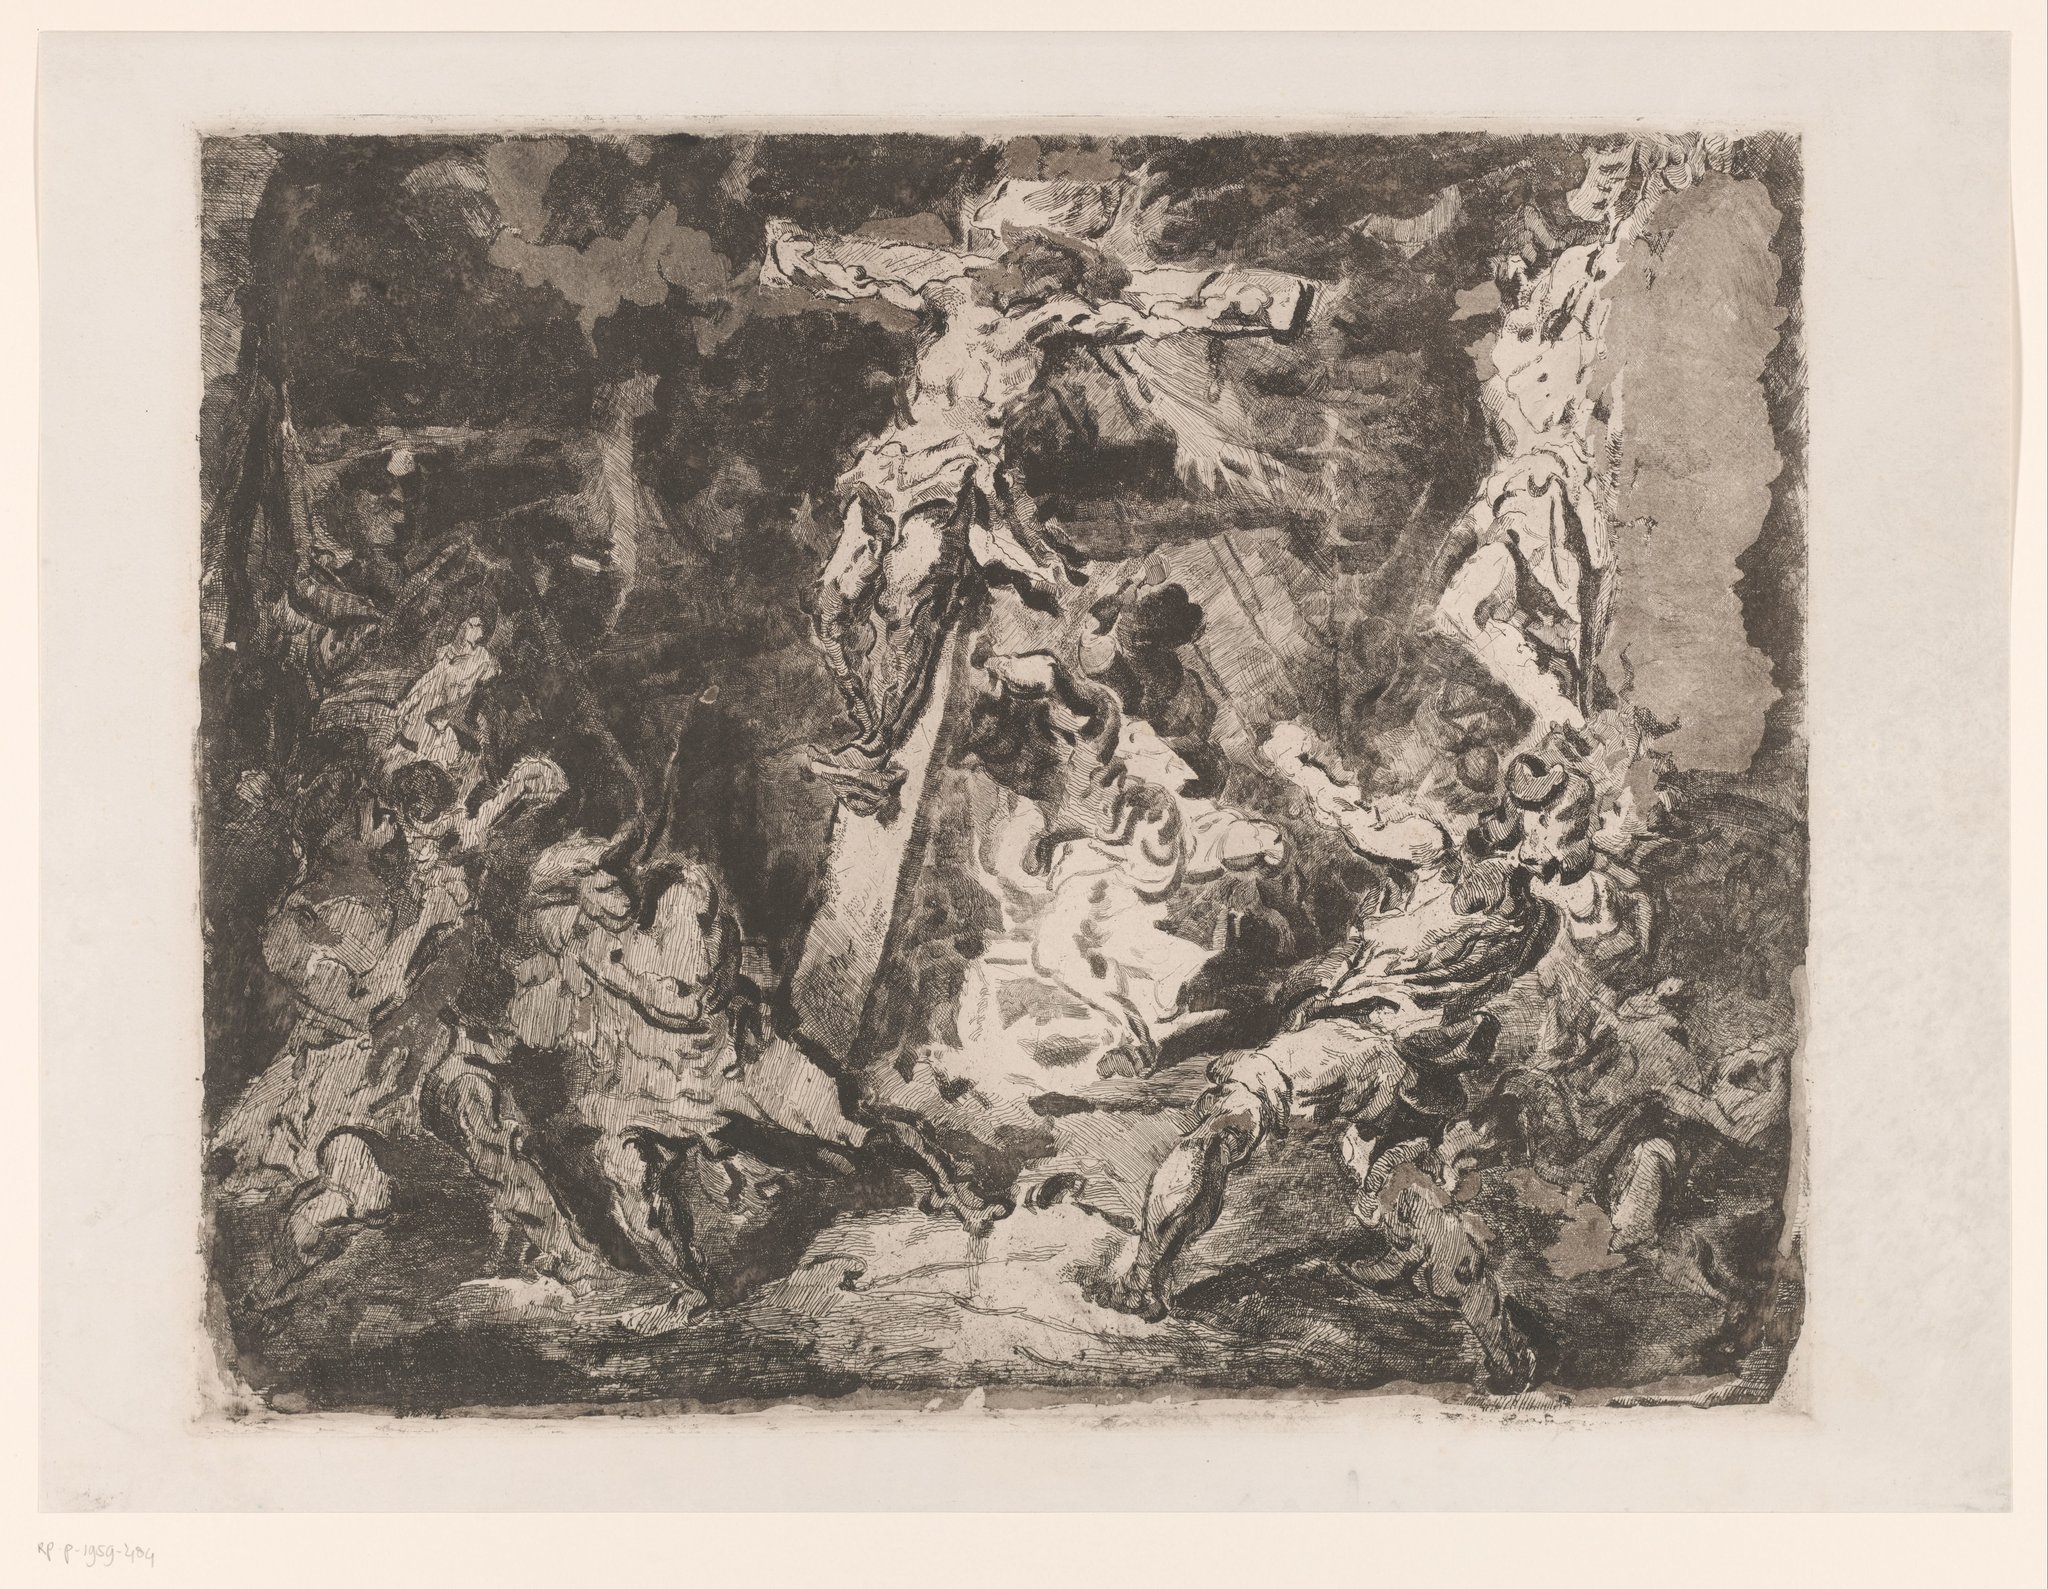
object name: print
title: Christus aan het kruis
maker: barbara elisabeth van houten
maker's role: draughtsman, print maker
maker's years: 1862-1950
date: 1872-1950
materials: paper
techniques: etching, intaglio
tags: the crucifixion of christ: christ's death on the cross; golgotha (matthew 27:45-58; mark 15:33-45; luke 23:44-52; john 19:25-38)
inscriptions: collector's mark: Lugt 2228